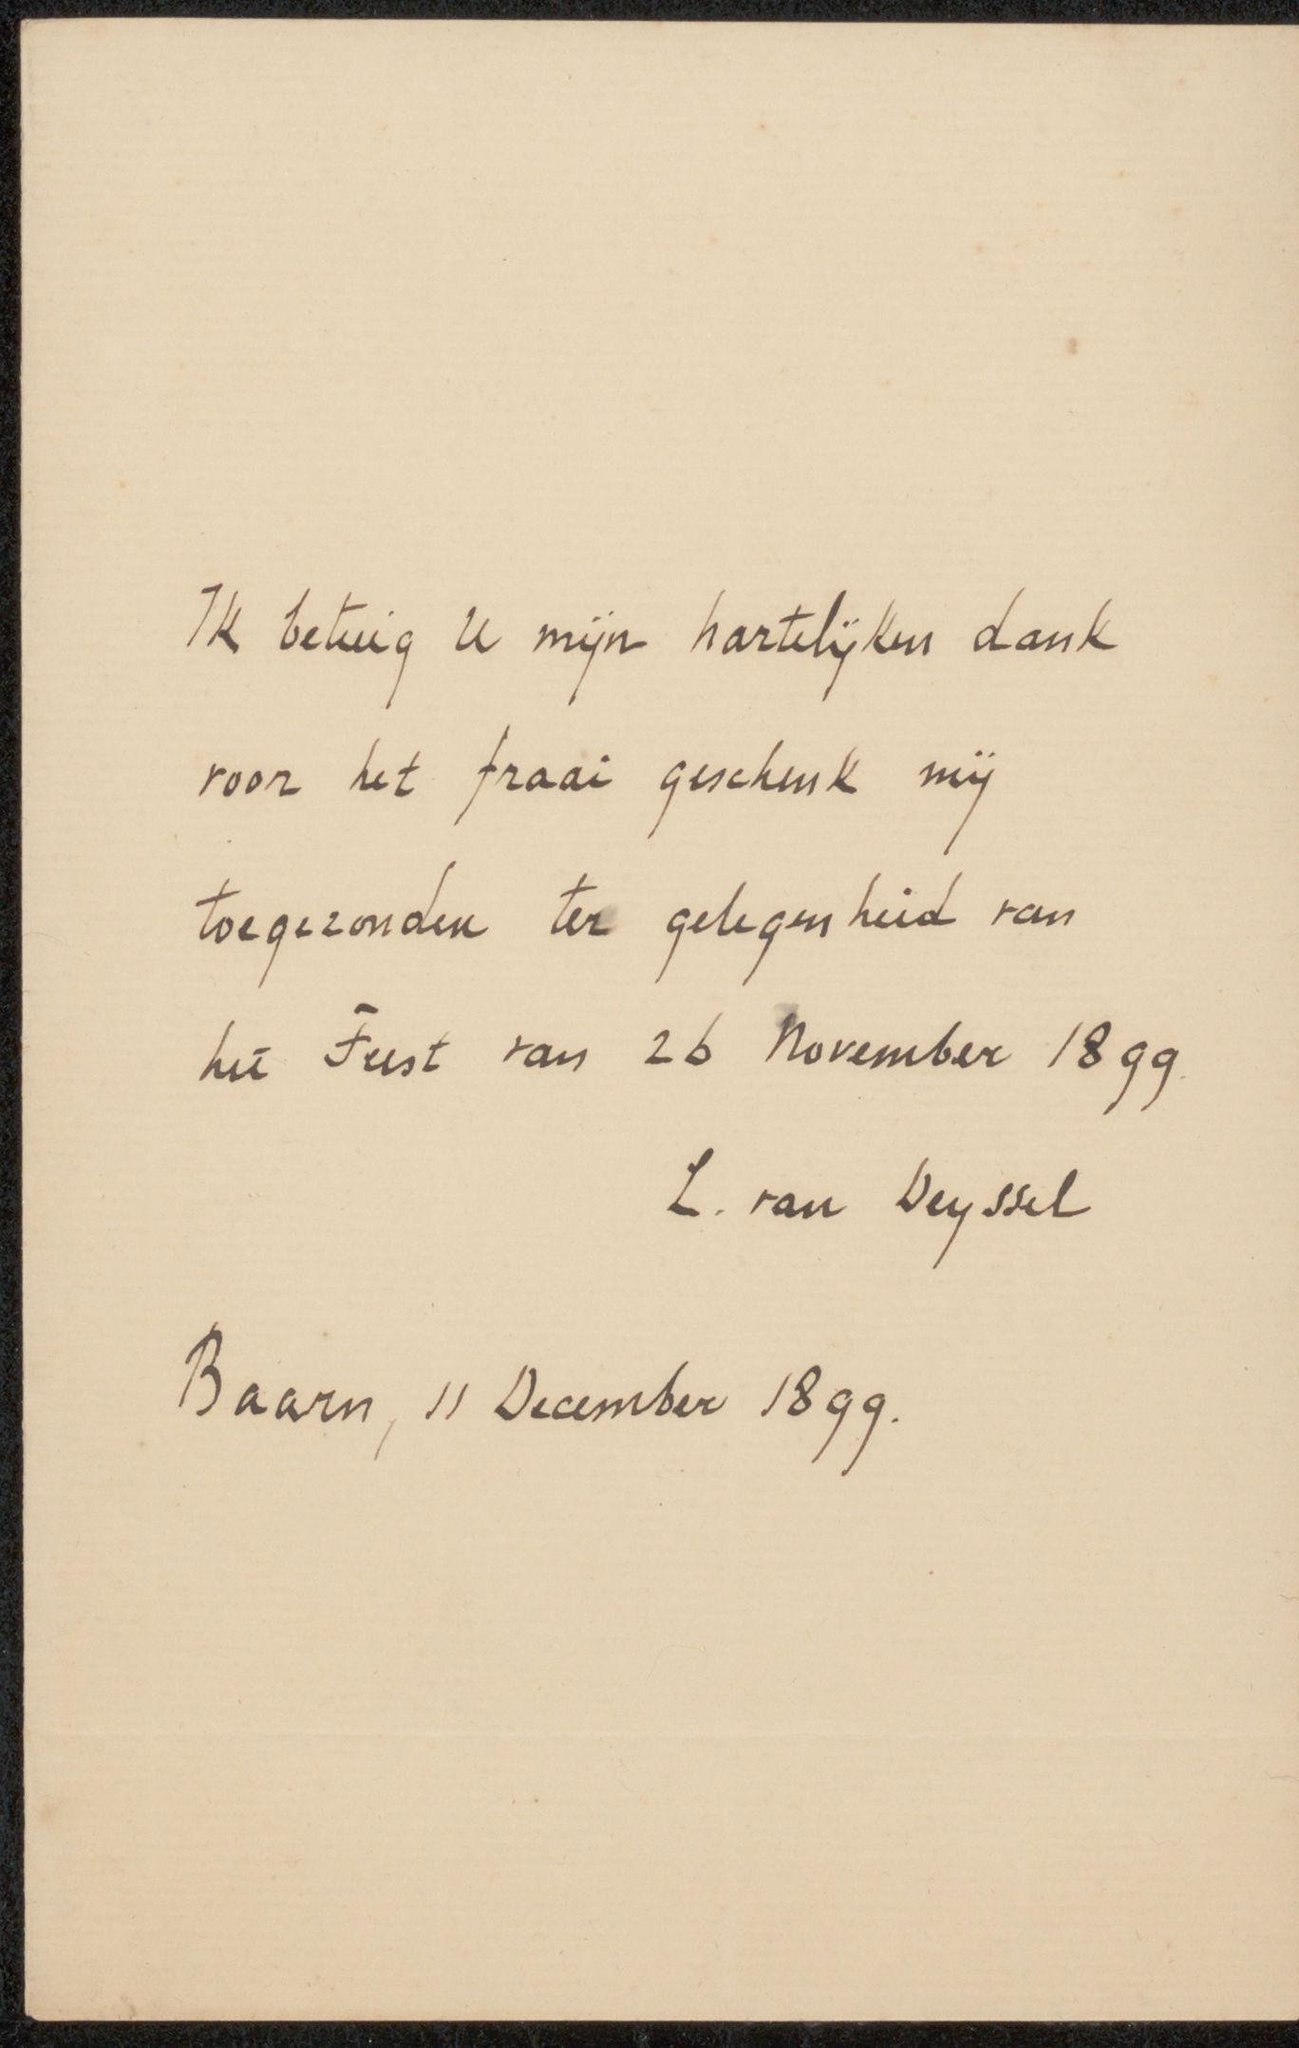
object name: letter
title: Brief aan Philip Zilcken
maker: karel johan lodewijk alberdingk thijm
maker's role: criticus, prozaschrijver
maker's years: 1864-1952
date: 1899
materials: ink, paper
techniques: pen, writing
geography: baarn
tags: the hague, painter, draughtsman, philip zilcken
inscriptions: collector's mark: ‘RPK’